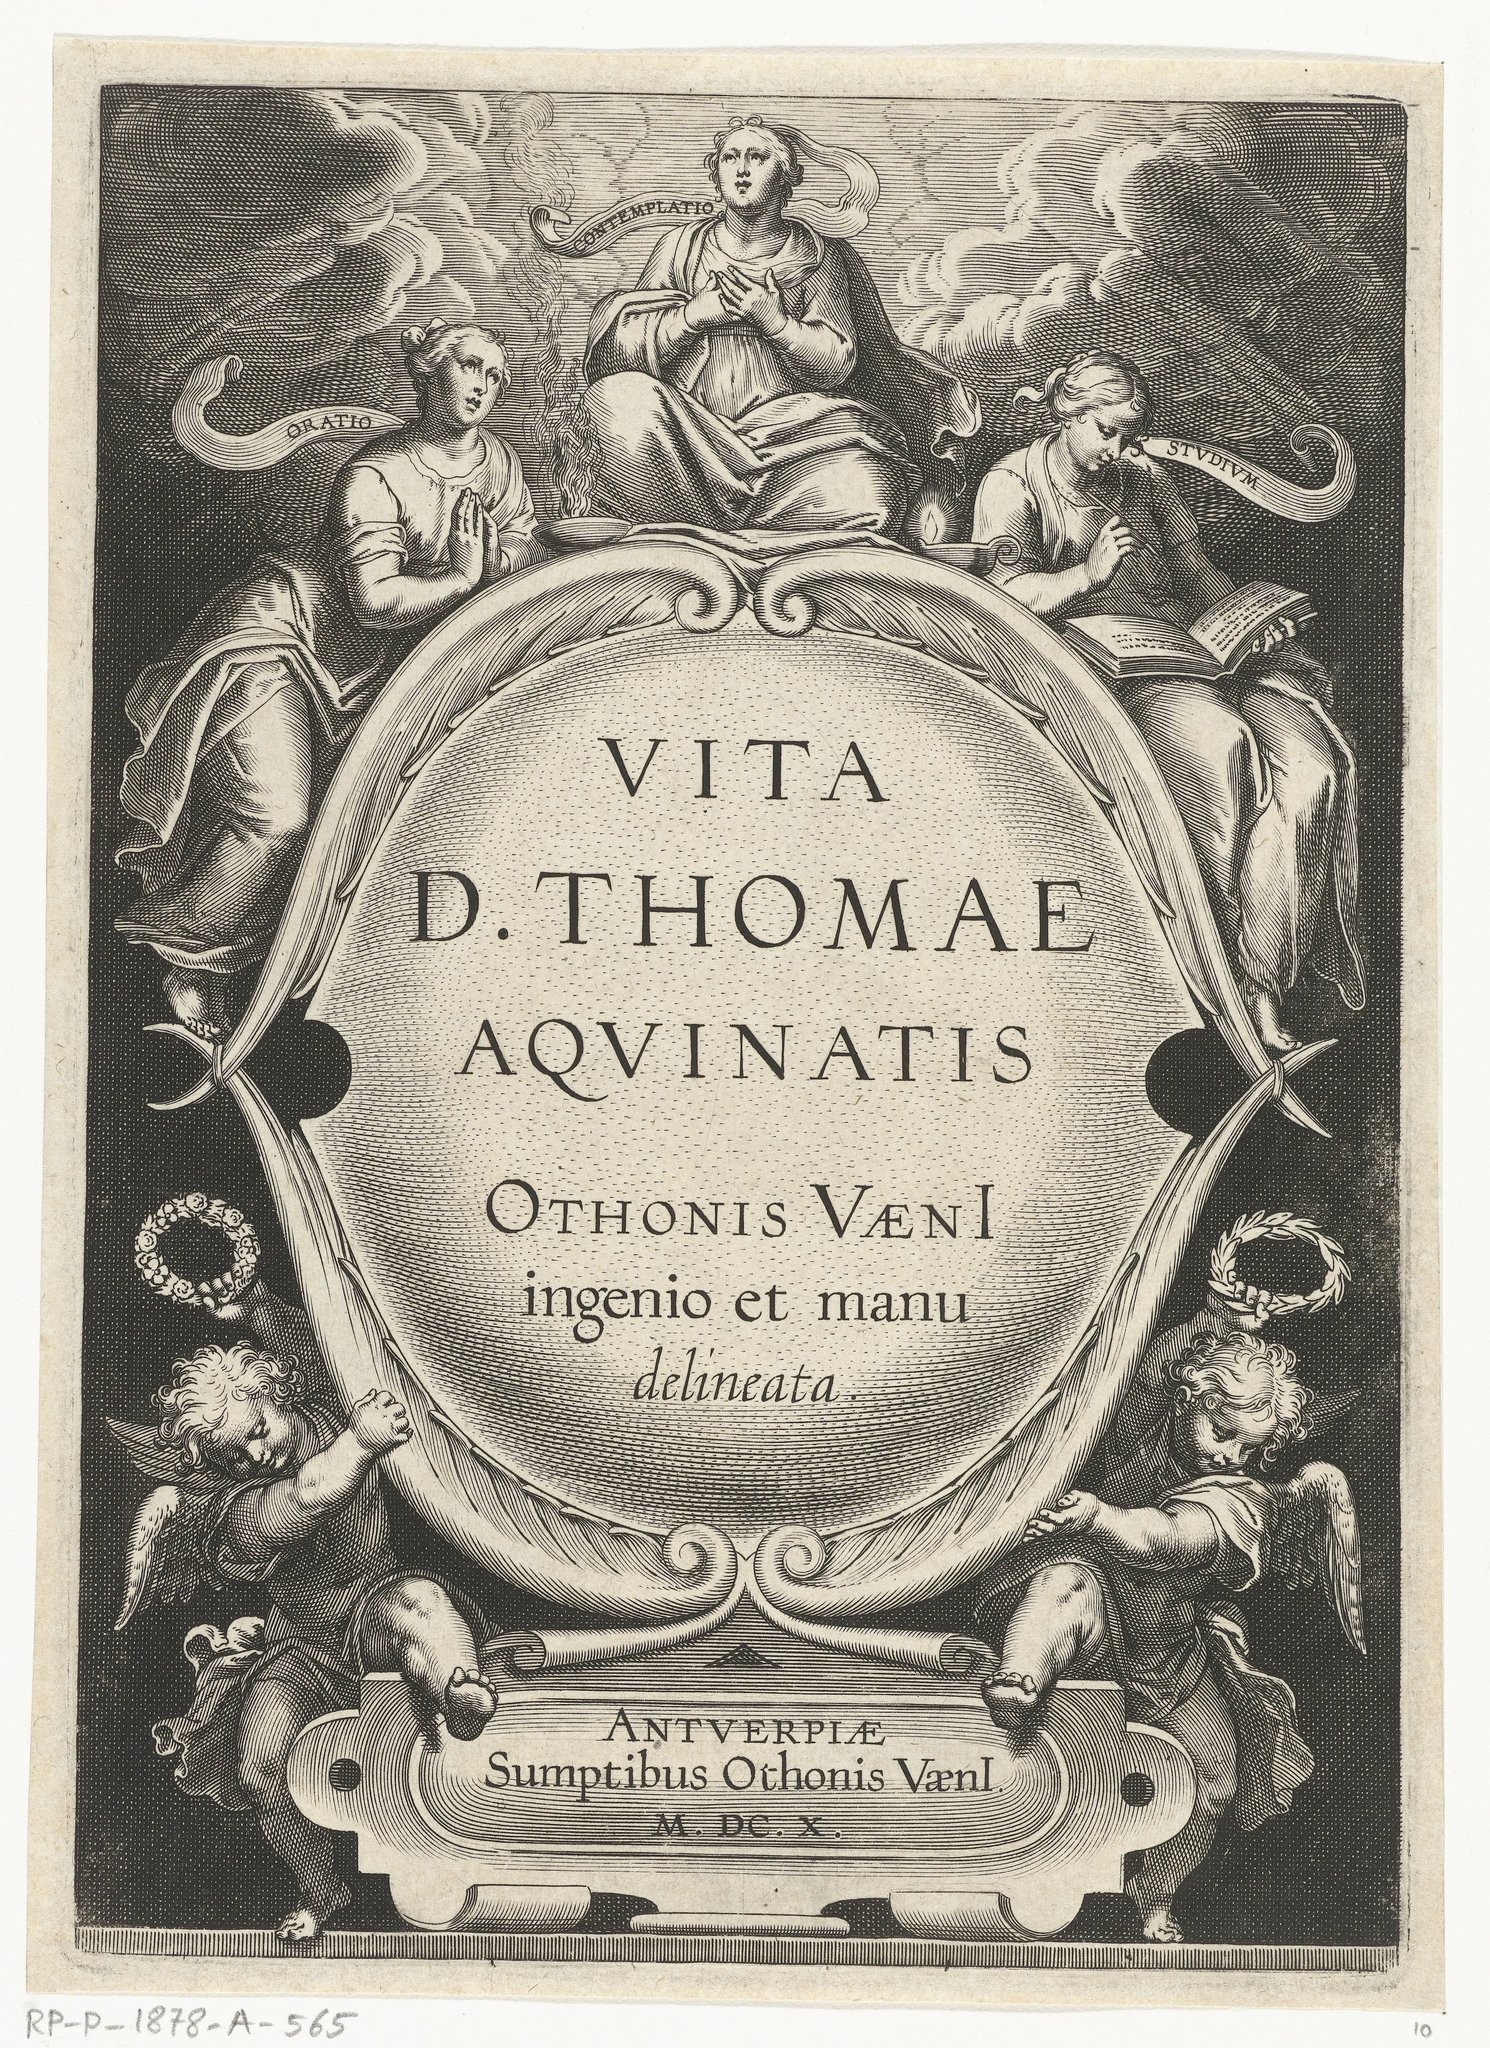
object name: titelprent, frontispice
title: Het leven van de heilige Thomas van Aquino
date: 1610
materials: paper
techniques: engraving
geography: southern netherlands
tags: thomas van aquino, the dominican theologian, 'angelic doctor' thomas of aquino; possible attributes: book, (chain with) sun, dove, girdle of chastity, lily, model of church, monstrance (or chalice), mitre (under feet), star (on breast)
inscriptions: collector's mark: Lugt 2228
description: Titelprent voor een serie van 30 prenten die het levensverhaal van Thomas van Aquino verbeelden. De prenten, naar ontwerp van en uitgegeven door Otto van Veen, zijn door C. Boel, E. van Paenderen, C. Galle en G. Swanenburgh vervaardigd.